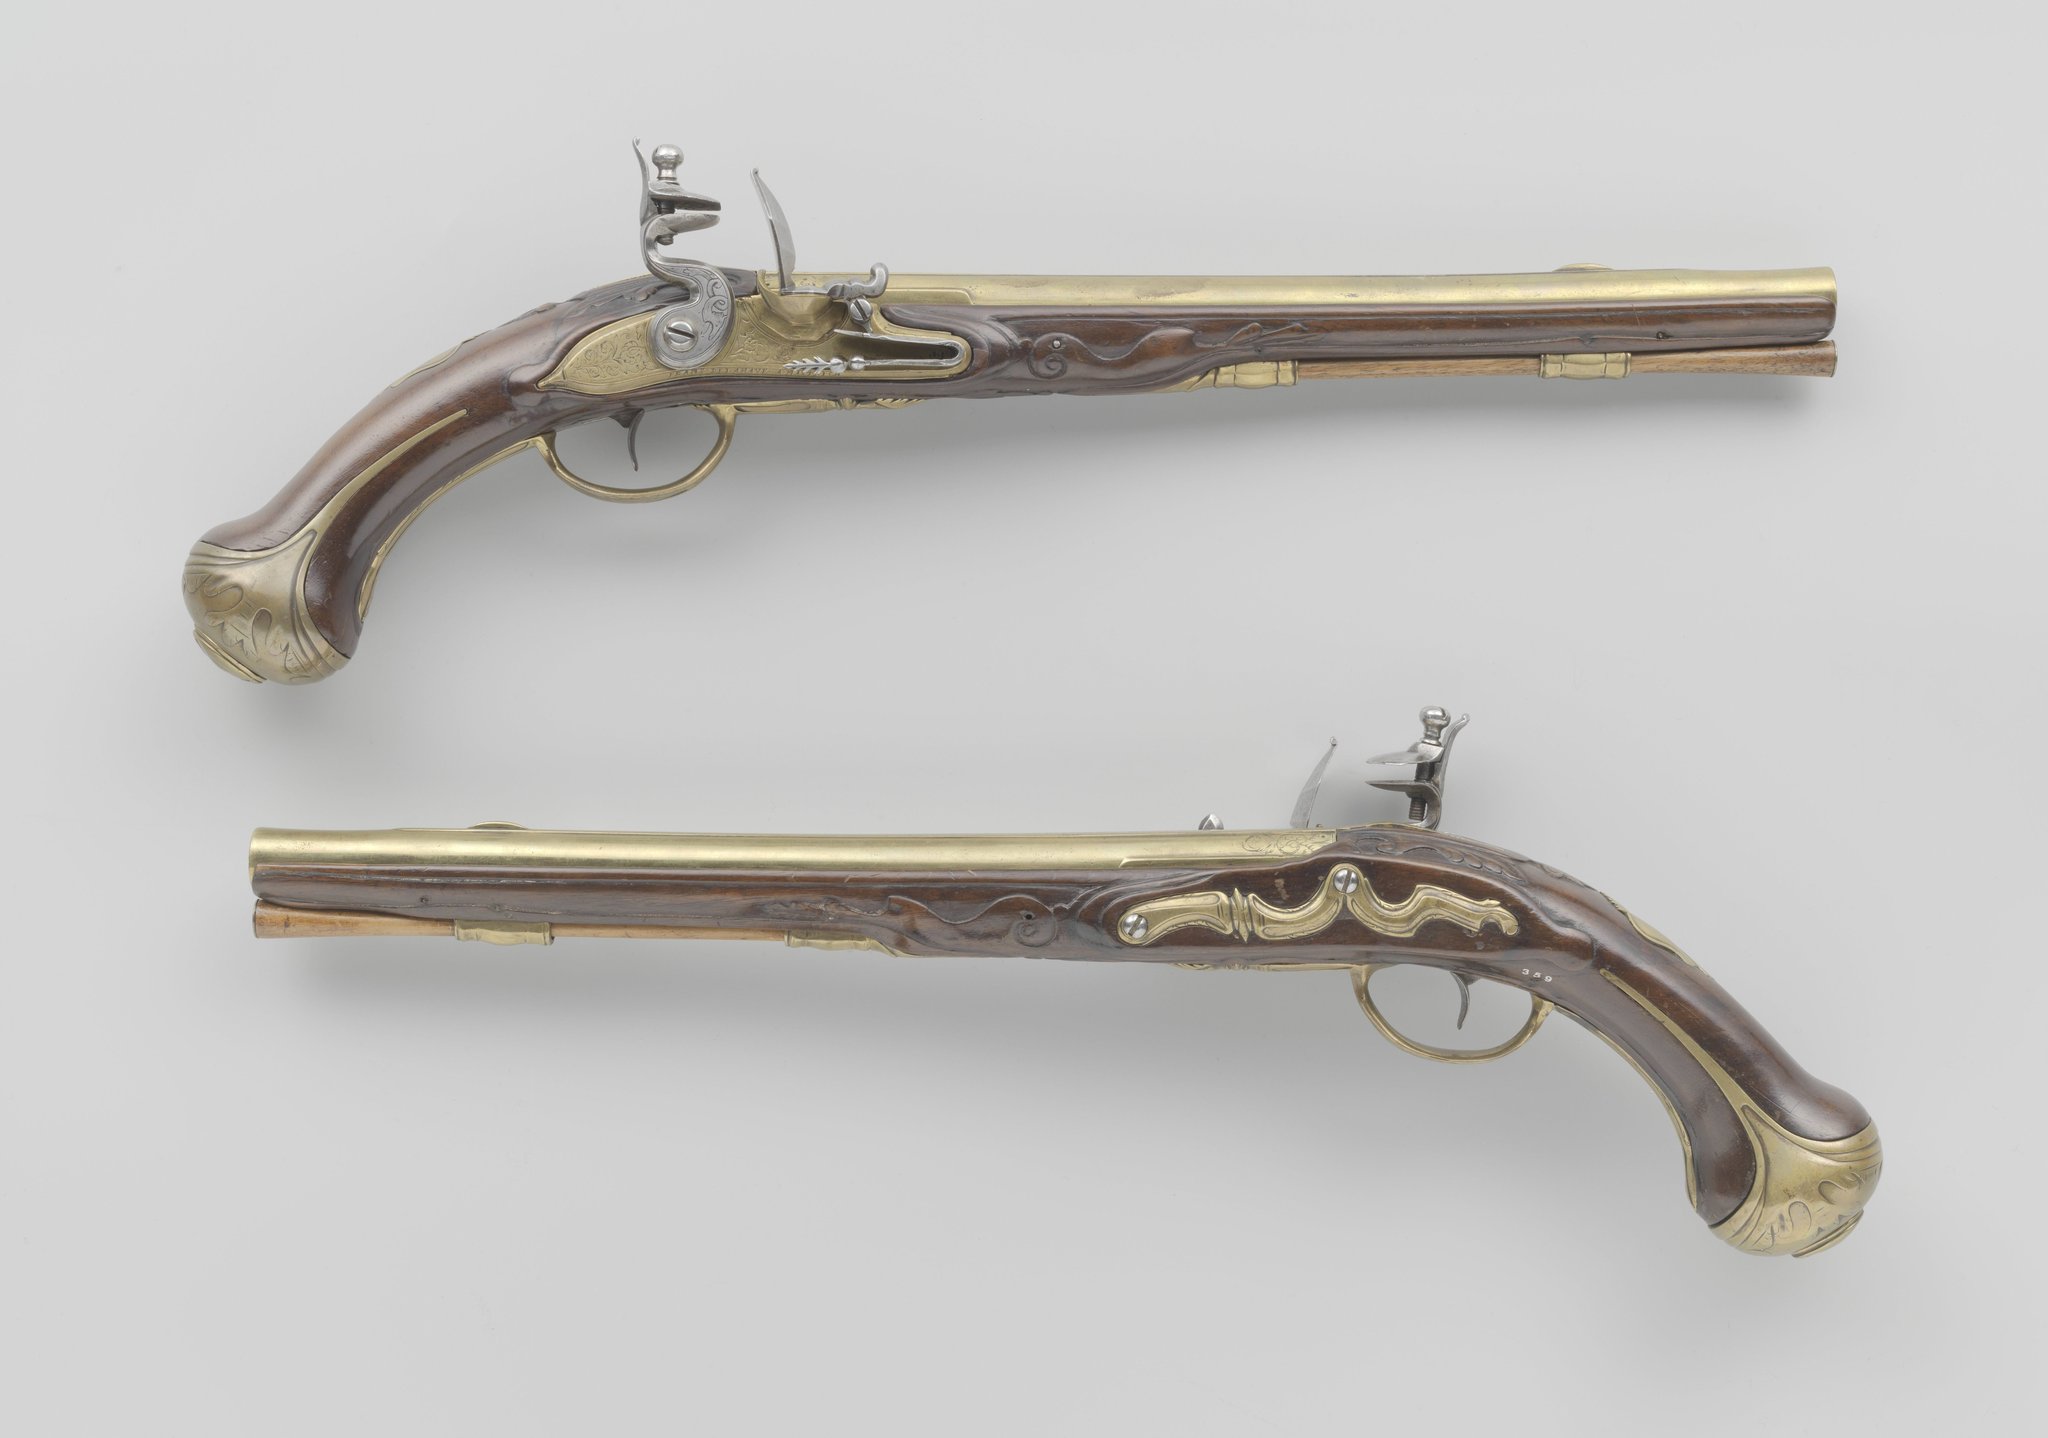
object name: flintlock pistol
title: Vuursteenpistool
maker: frans delahaye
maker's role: geweermaker, pistoolmaker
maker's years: 1673-1753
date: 1720-1730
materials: wood, brass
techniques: printing, cutting, engraving, gilding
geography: maastricht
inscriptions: inscription: ‘FRANS.DELAHAYE.A.MASTRICH’, : ‘I’